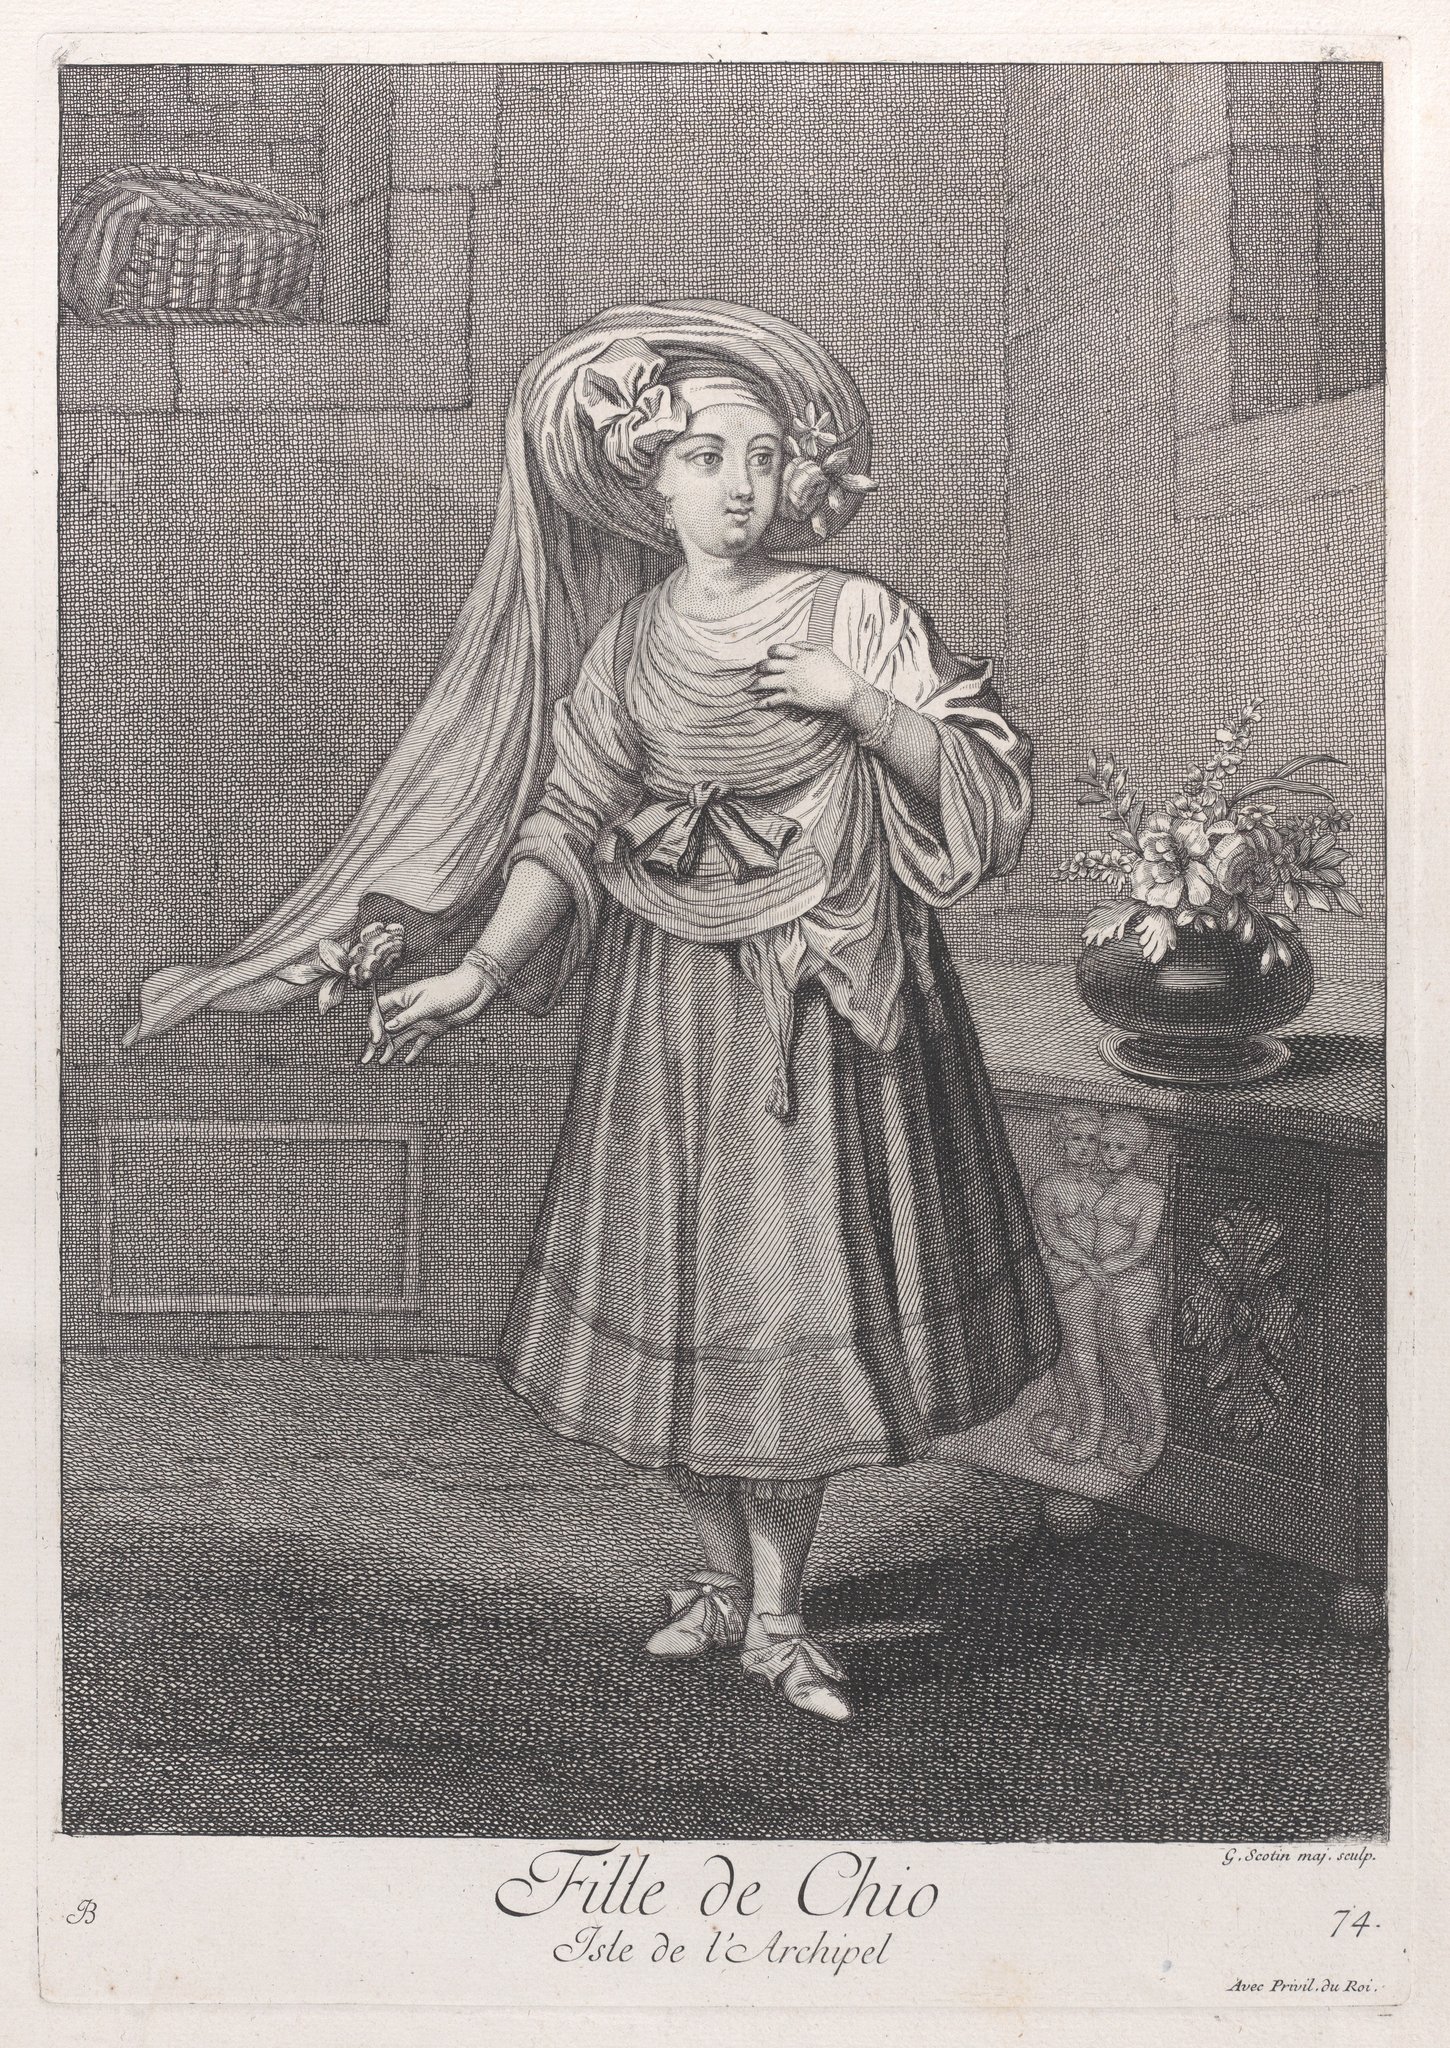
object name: print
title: Fille de Chio, Isle de l'Archipel, plate 74 from "Recueil de cent estampes représentent differentes nations du Levant"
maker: jean baptiste vanmour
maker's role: artist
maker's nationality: french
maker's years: 1671-1737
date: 1714-1715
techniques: engraving, etching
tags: women